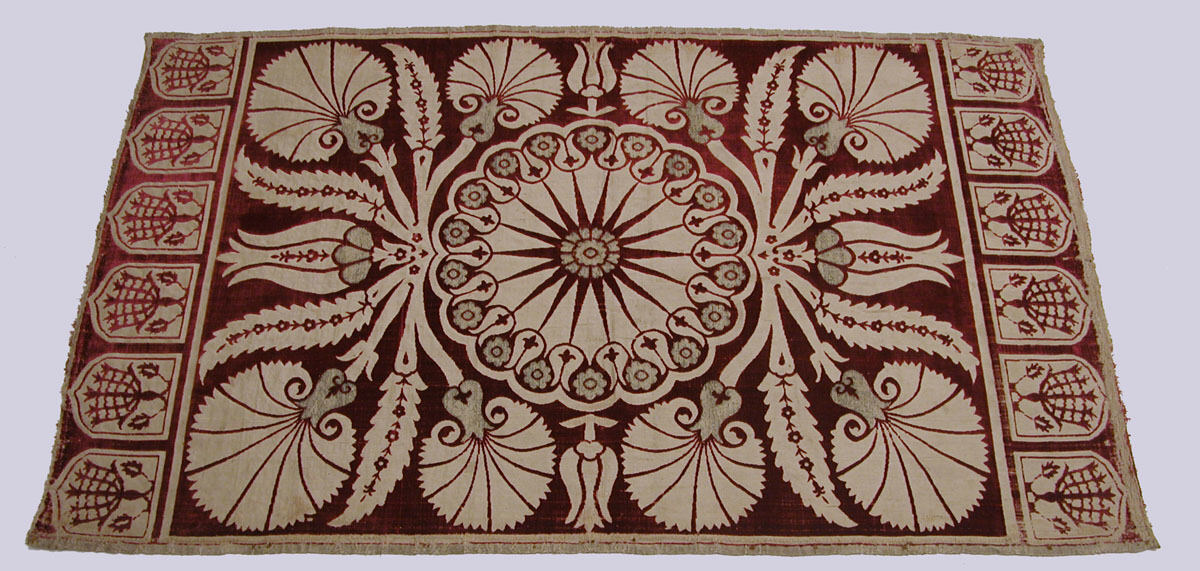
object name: cushion cover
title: Cushion Cover (Yastik)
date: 1601-1700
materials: cotton, metal thread, silk, velvet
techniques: brocade, cutting, voiding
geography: turkey